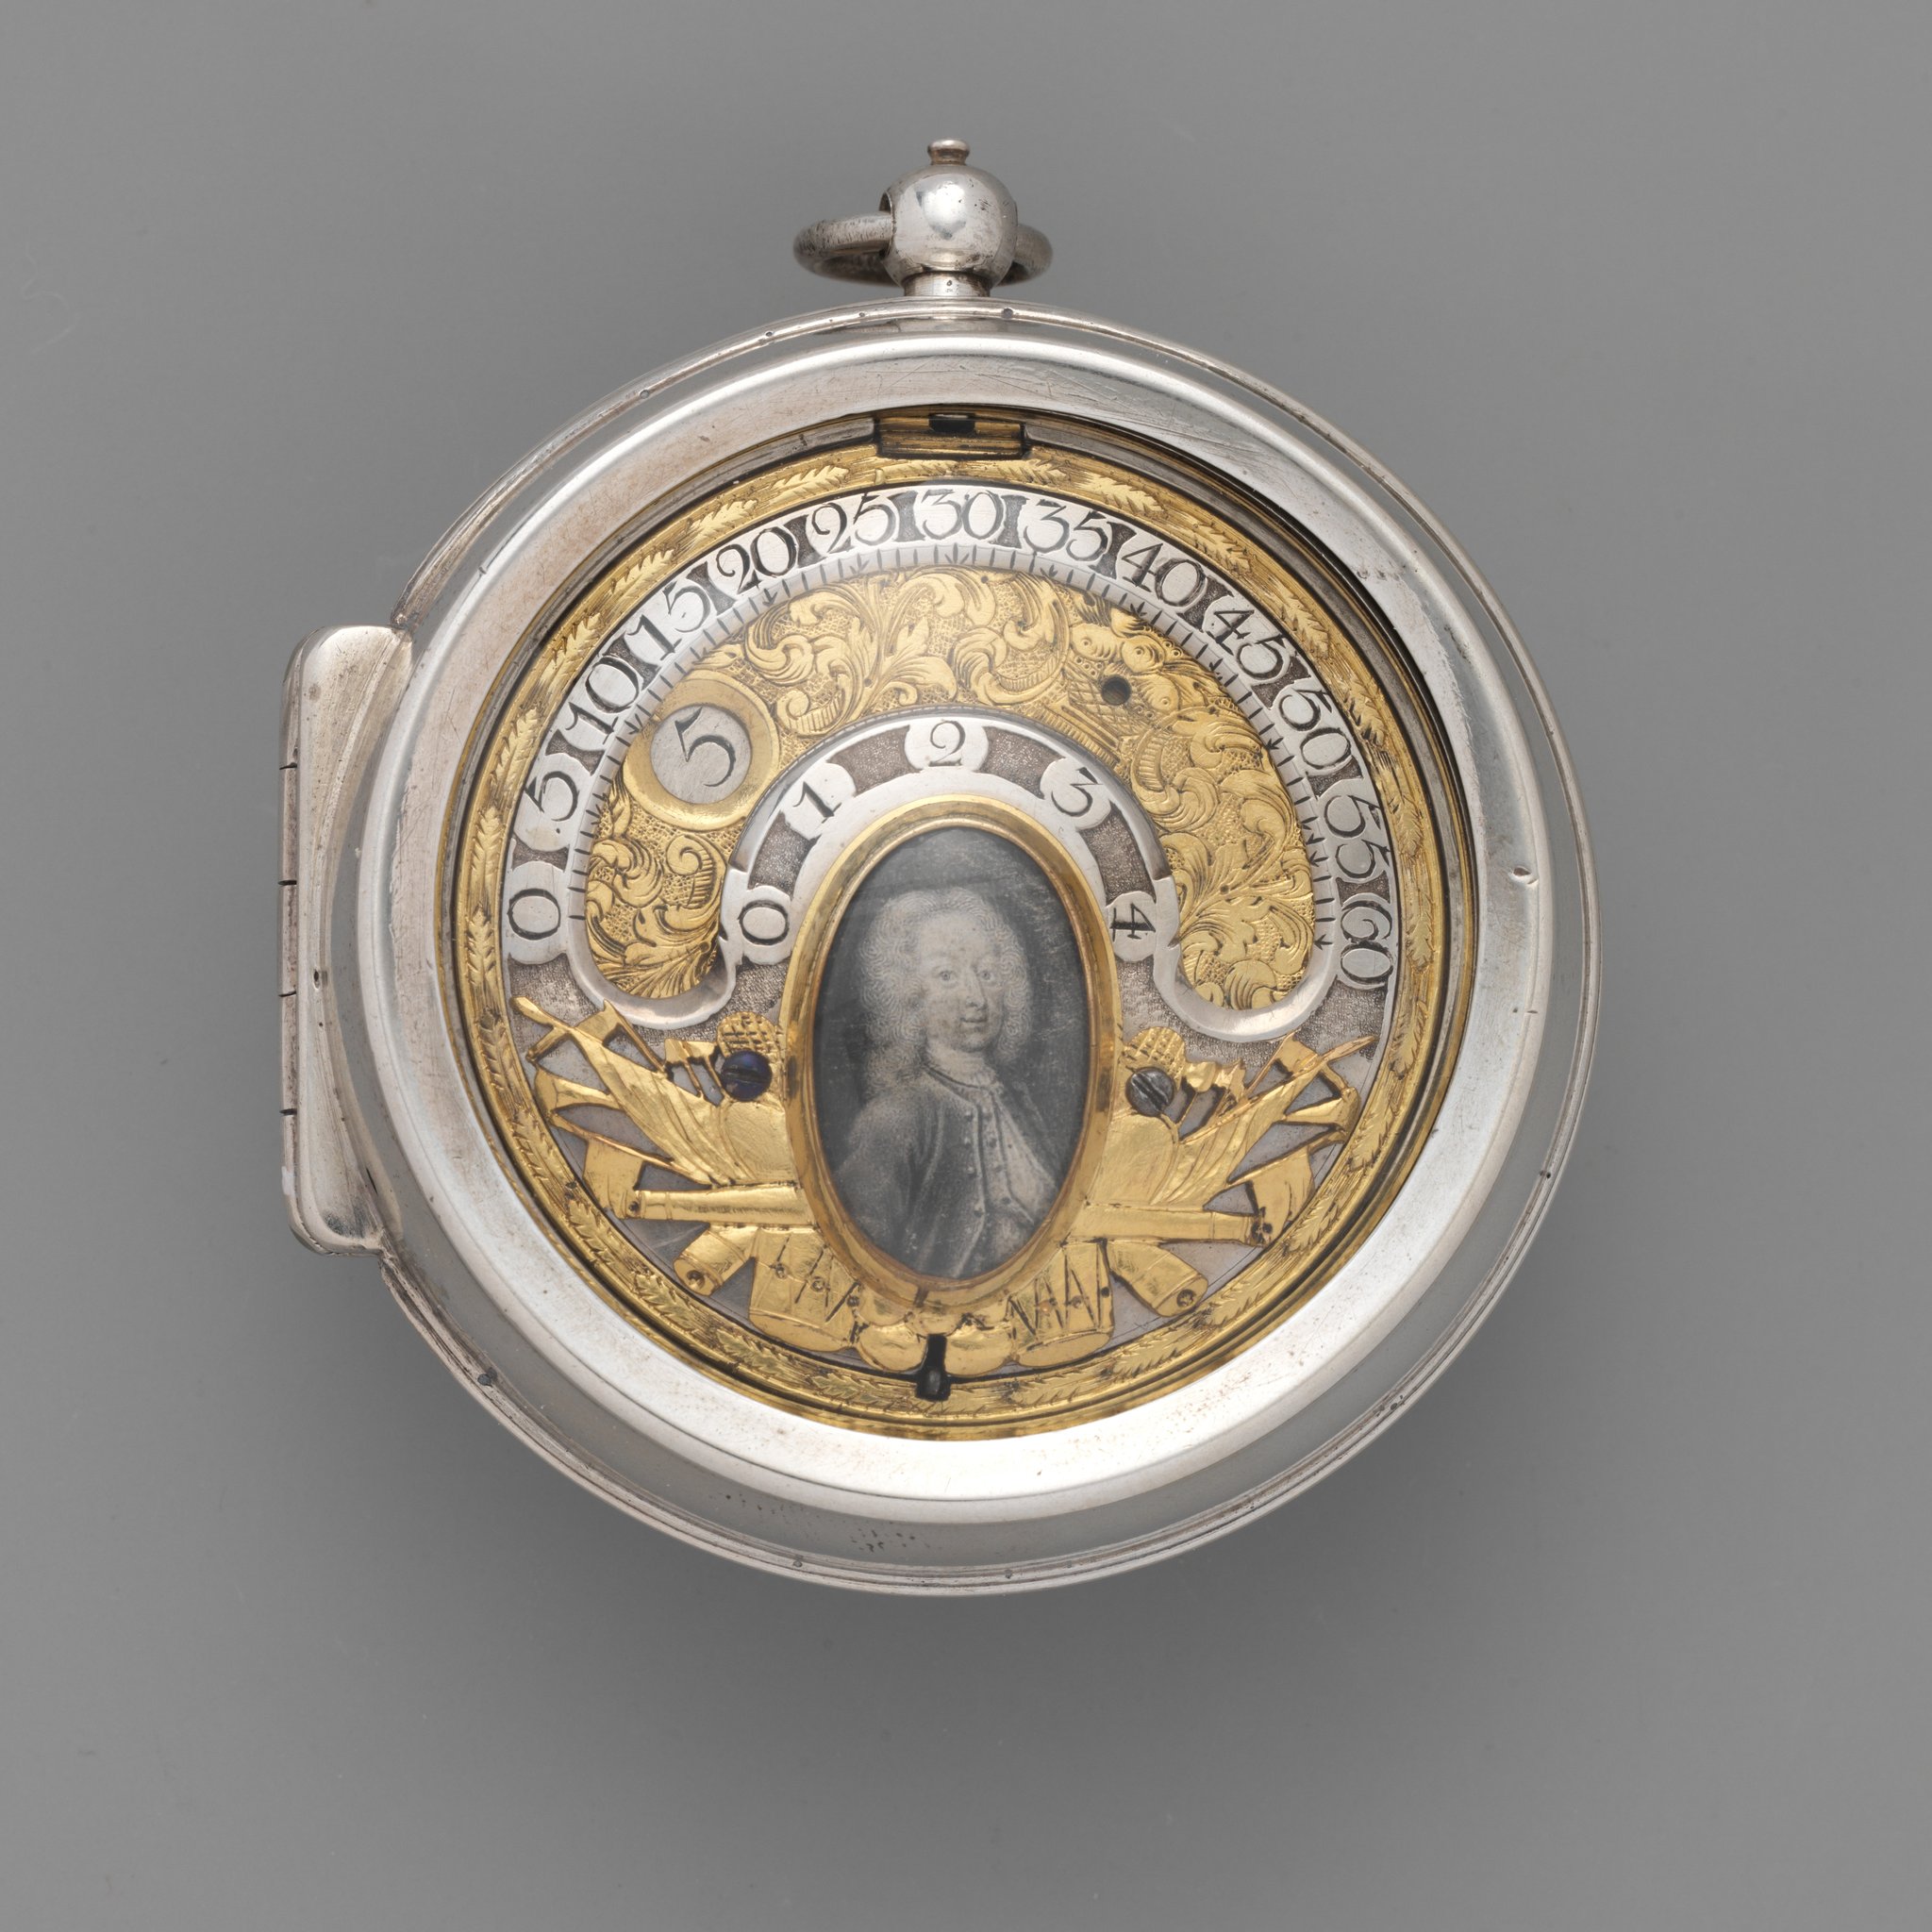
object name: watch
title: Watch with wandering hour dial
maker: thomas tompion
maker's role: maker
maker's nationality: british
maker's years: 1639-1713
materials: gilt, metal, silver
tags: men,portraits